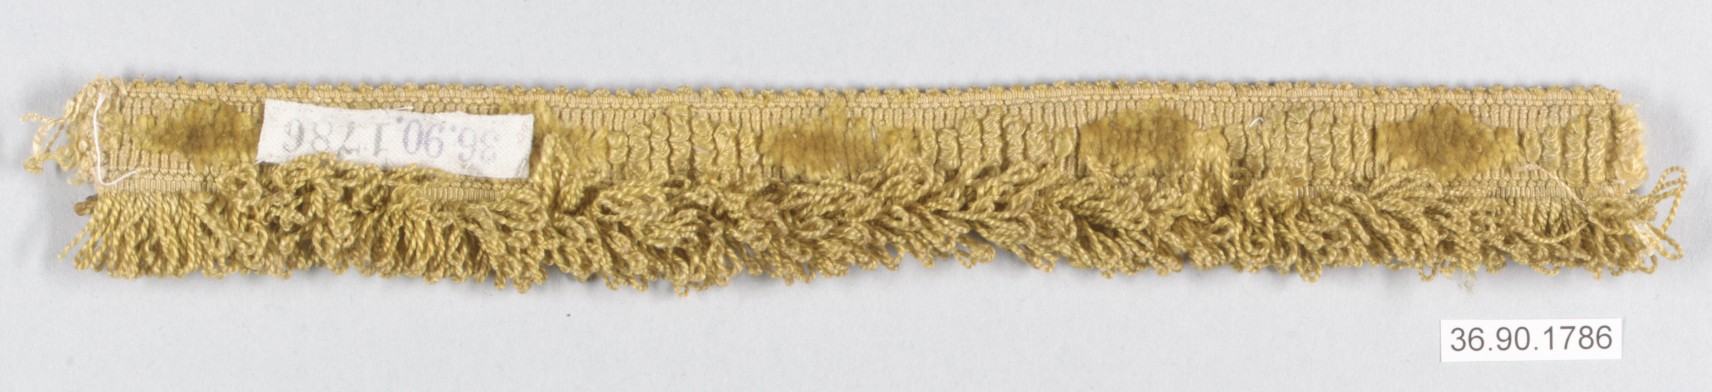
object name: fringe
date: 1867-1900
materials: silk